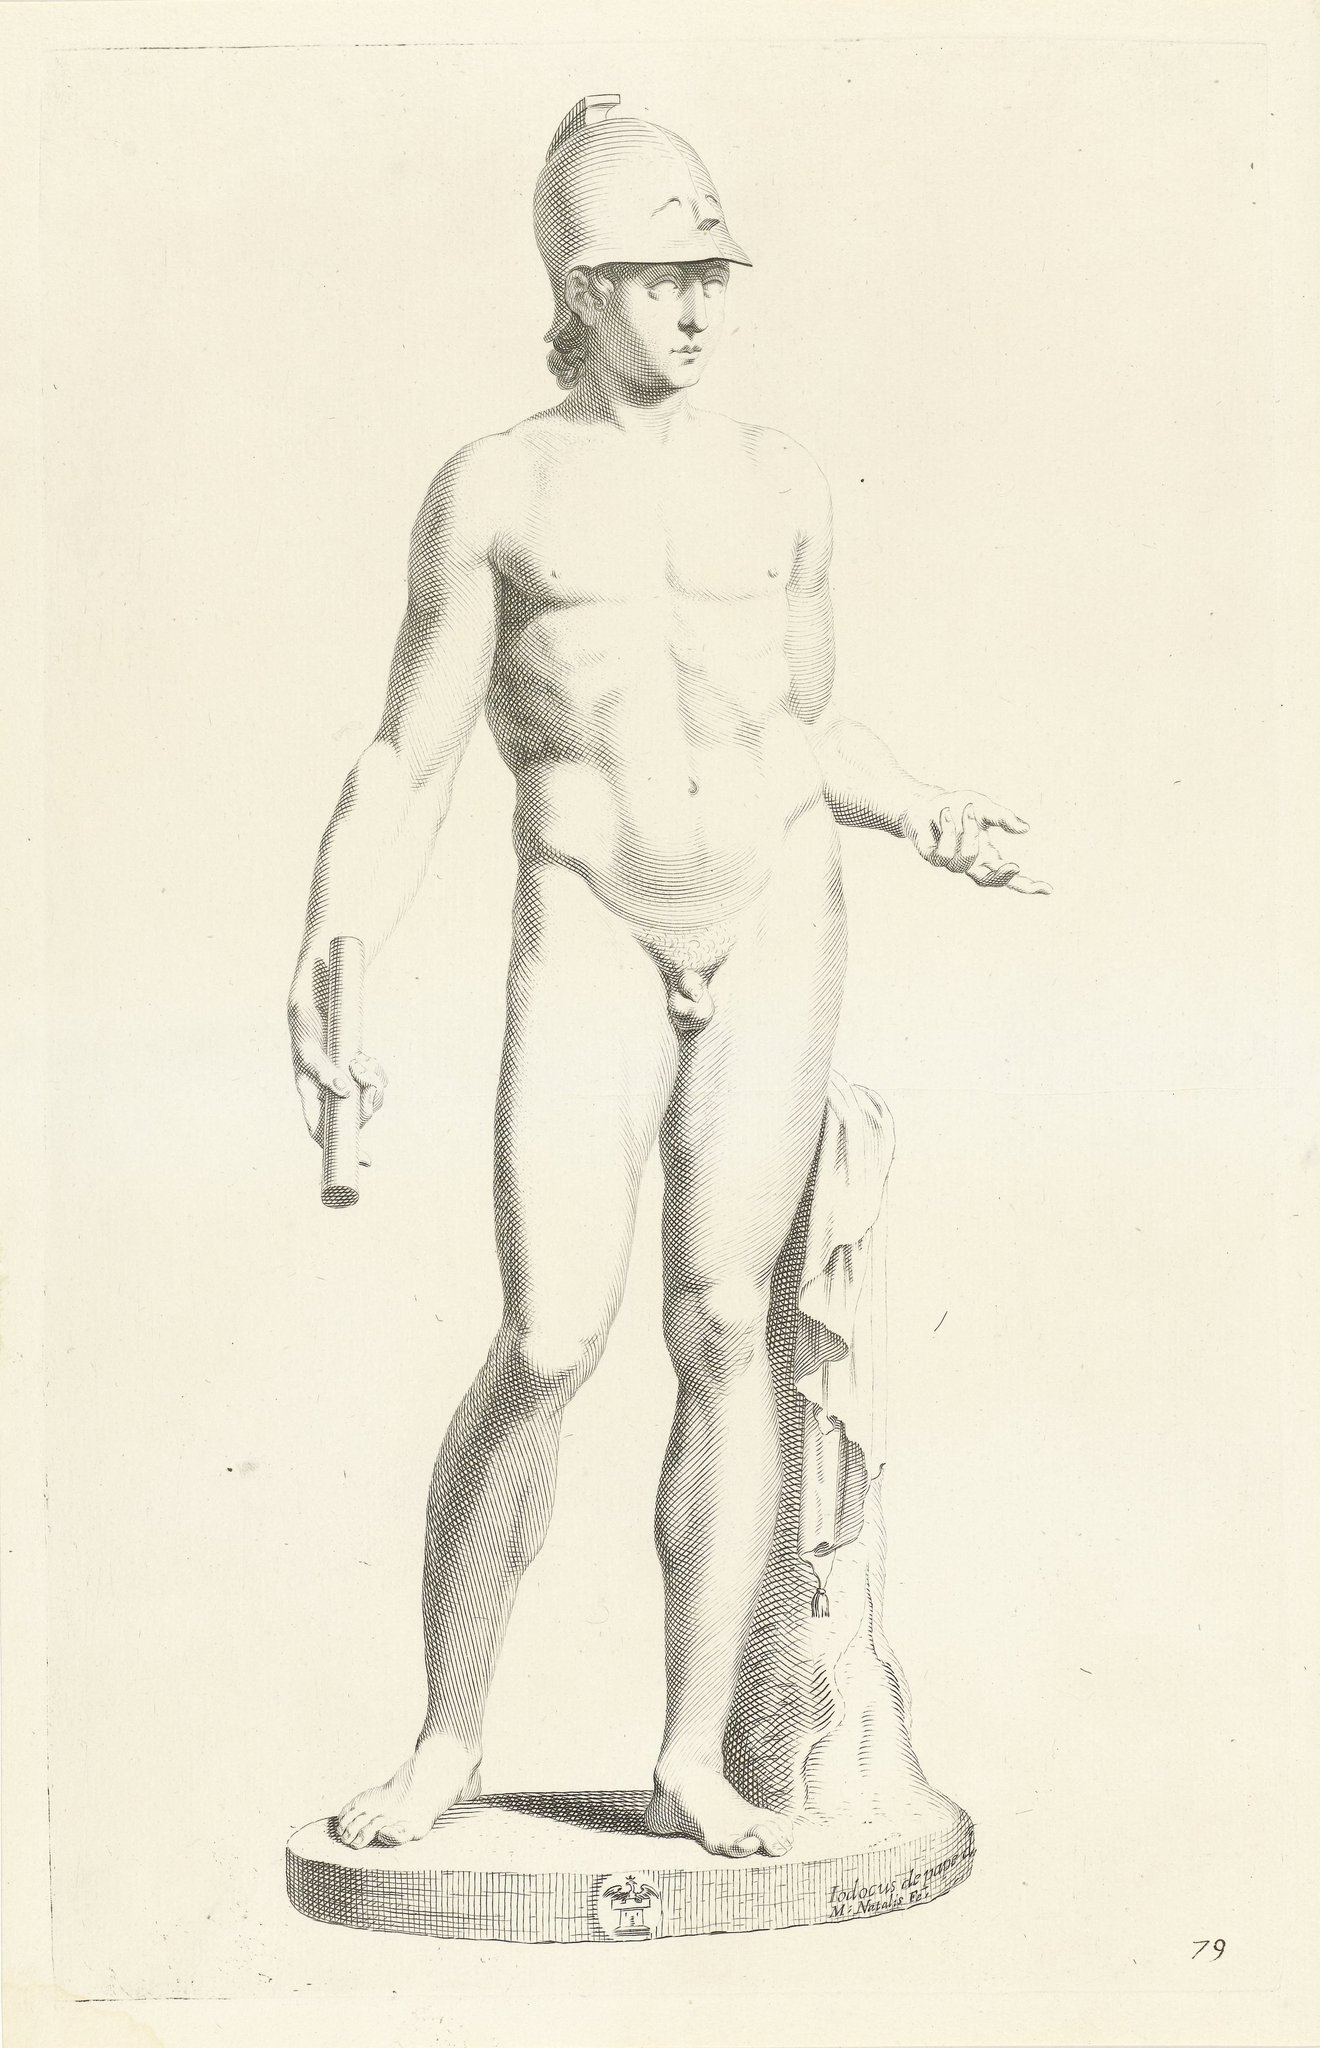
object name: print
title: Standbeeld van Mercurius met helm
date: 1640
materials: paper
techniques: engraving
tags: vincenzo giustiniani (1564-1637), (story of) mercury (hermes), piece of sculpture, reproduction of a piece of sculpture, monument, statue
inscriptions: collector's mark: Lugt 2228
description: Standbeeld van de naakte Mercurius met een helm op het hoofd, een stok in zijn rechterhand, staand naast een boomstam. Midden onder op de basis het wapenschild van Vincenzo Giustiniani. Prent uit een serie naar de sculpturen in de verzameling in de Galleria Giustiniani te Rome.